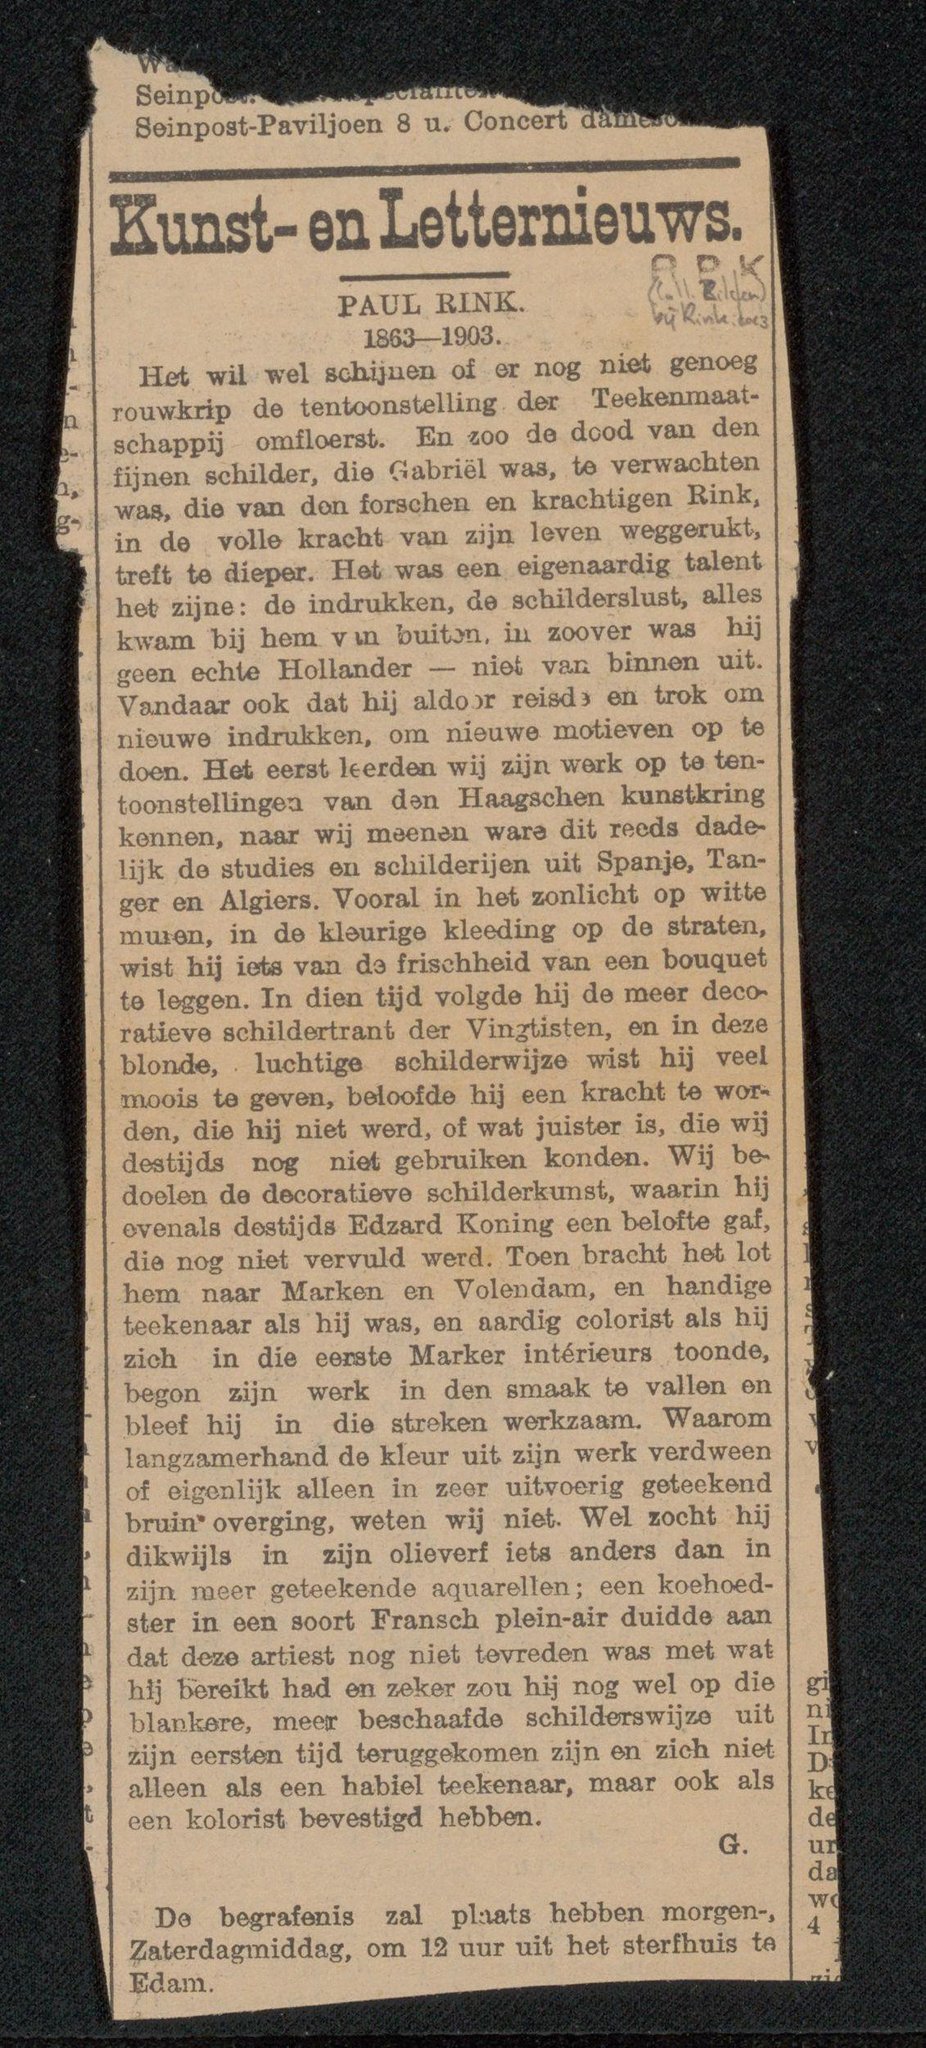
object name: newspaper clipping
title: Krantenknipsel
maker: Anonymous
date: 1903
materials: paper, ink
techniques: printing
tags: veghel, print maker, draughtsman, paul rink, painter, philip zilcken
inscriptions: collector's mark: ‘RPK’